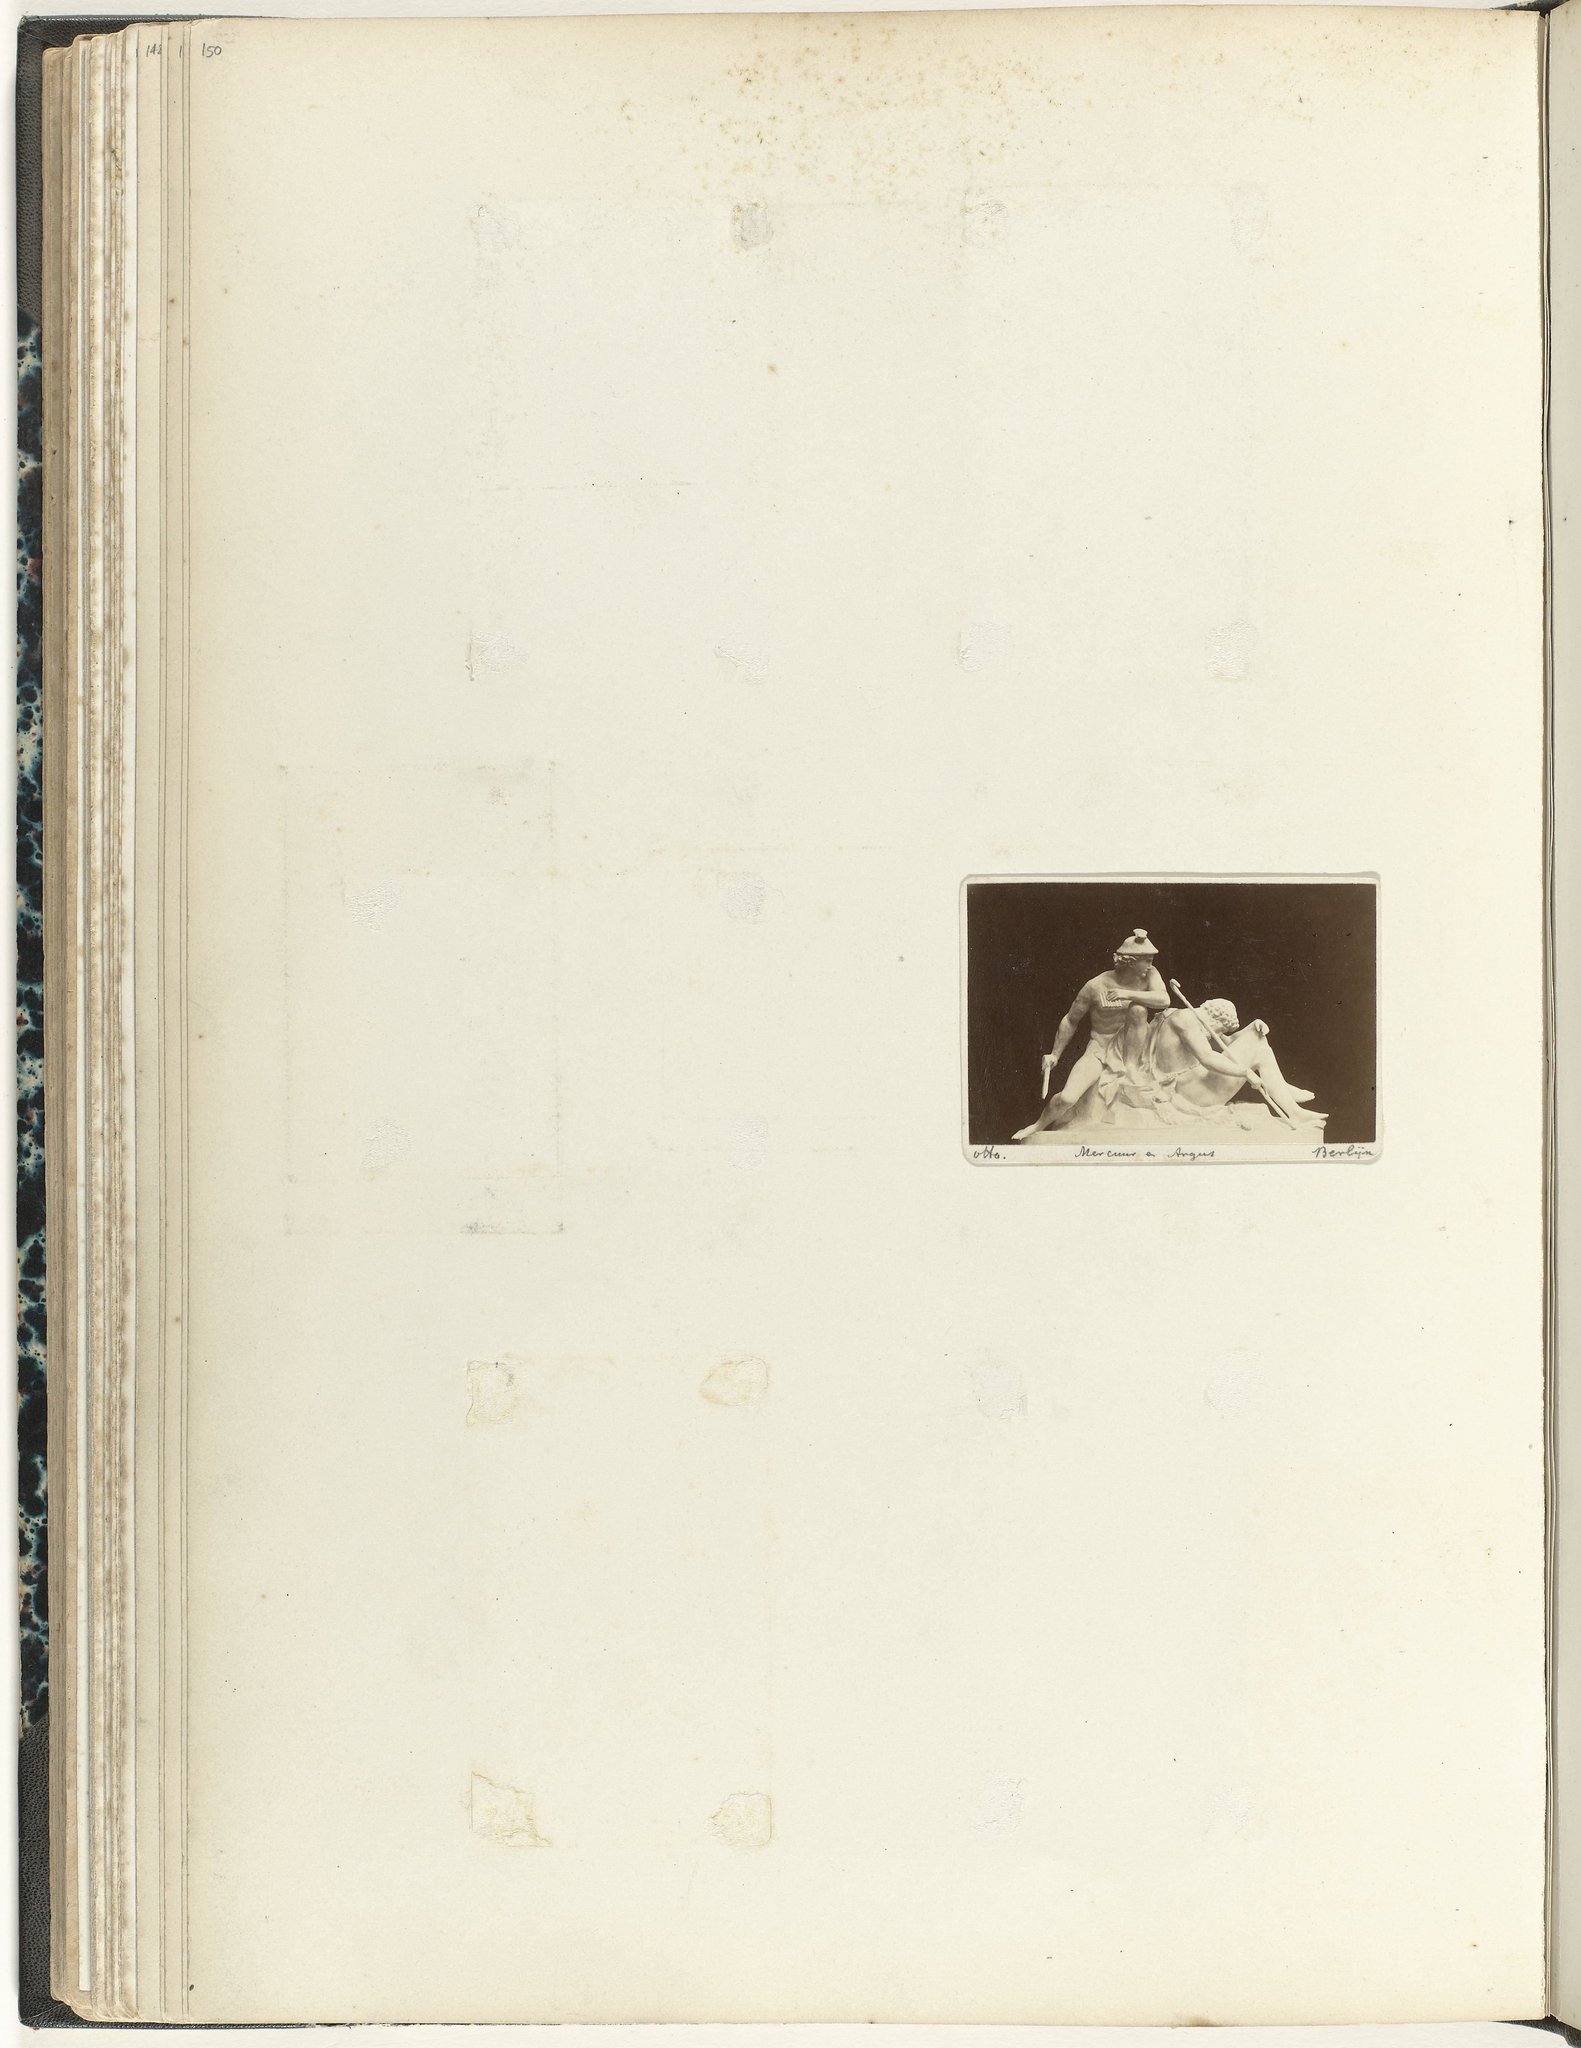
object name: photograph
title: Carte-de-visite met beeldhouwwerk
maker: Anonymous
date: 1866-1900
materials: cardboard, paper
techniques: albumen print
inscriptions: annotation: ‘Mercuur en Argus’, annotation: ‘Berlijn’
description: Beeld van Mercurius en Argus. Linksonder staat de naam Otto geschreven met potlood.